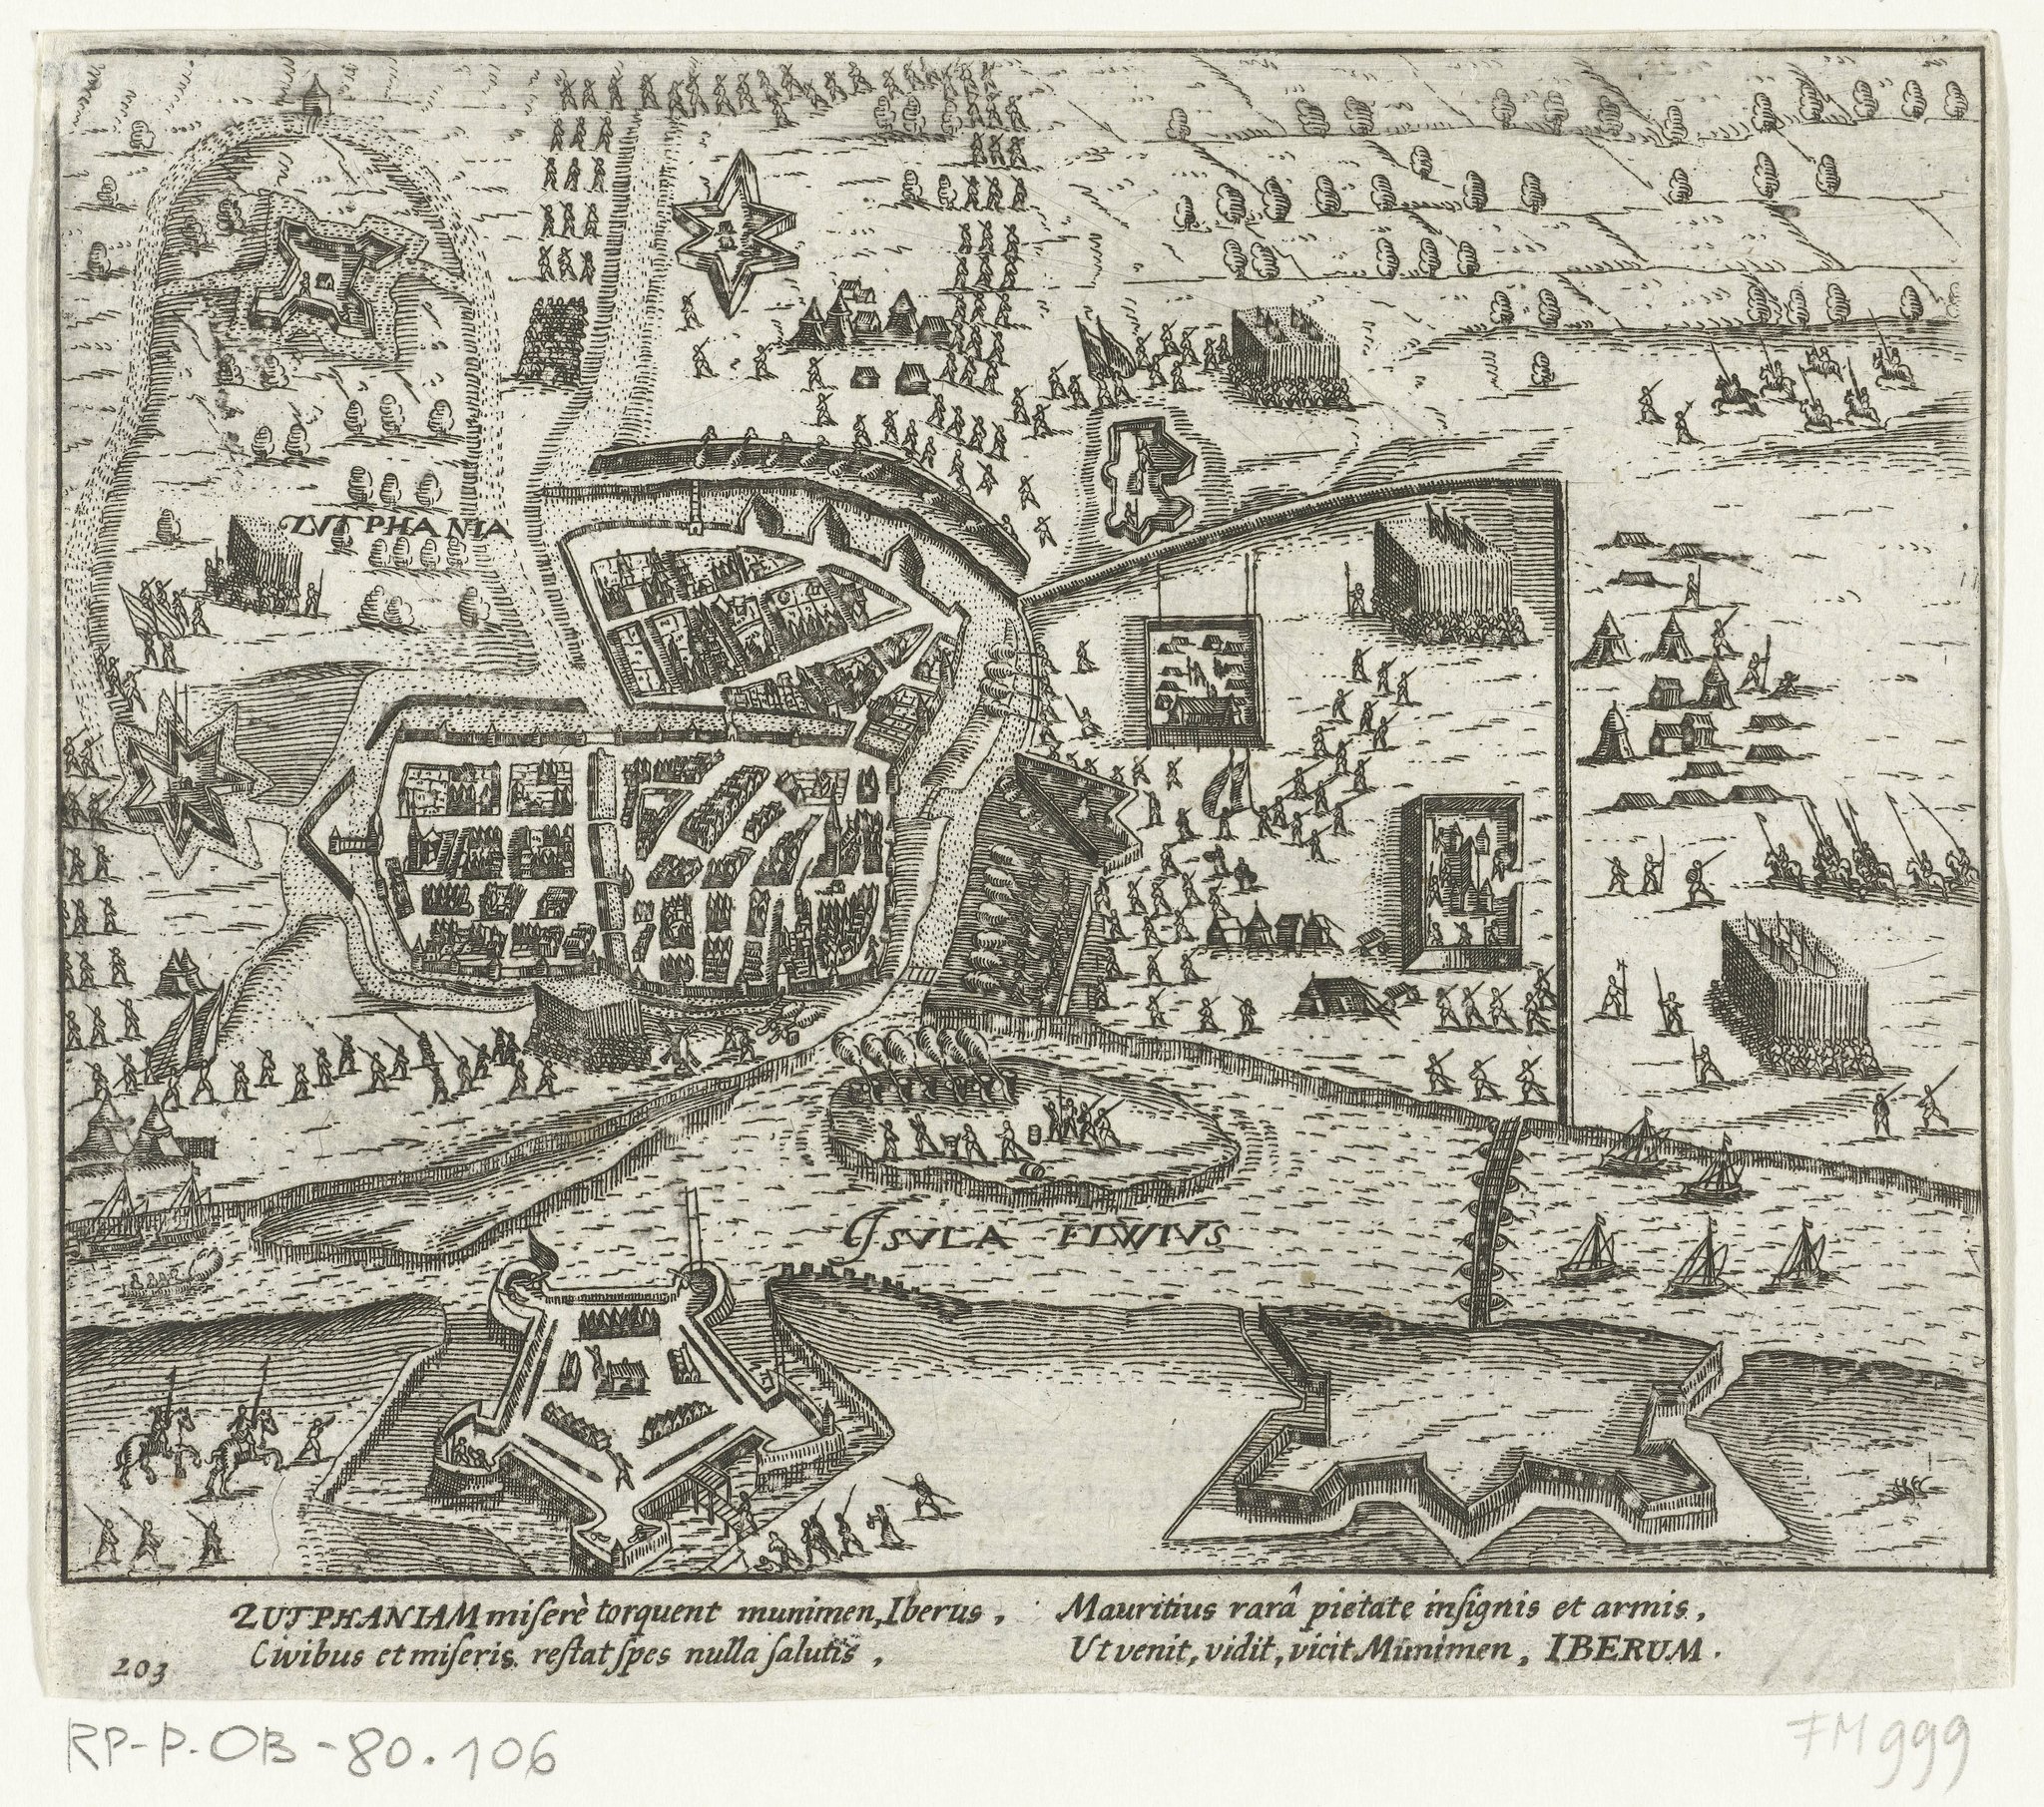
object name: history print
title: Inname van de schans bij Zutphen, 1591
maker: Anonymous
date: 1613-1615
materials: paper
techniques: etching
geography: northern netherlands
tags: capture of city (after the siege)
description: Inname van de schans bij Zutphen bij verrassing door het Staatse leger, 24 mei 1591. Plan van Zutphen aan de IJssel en het omringende land met schansen. Met onderschrift van 4 regels in het Latijn. Genummerd 203. Bedrukt op achterzijde met tekst in het Latijn.